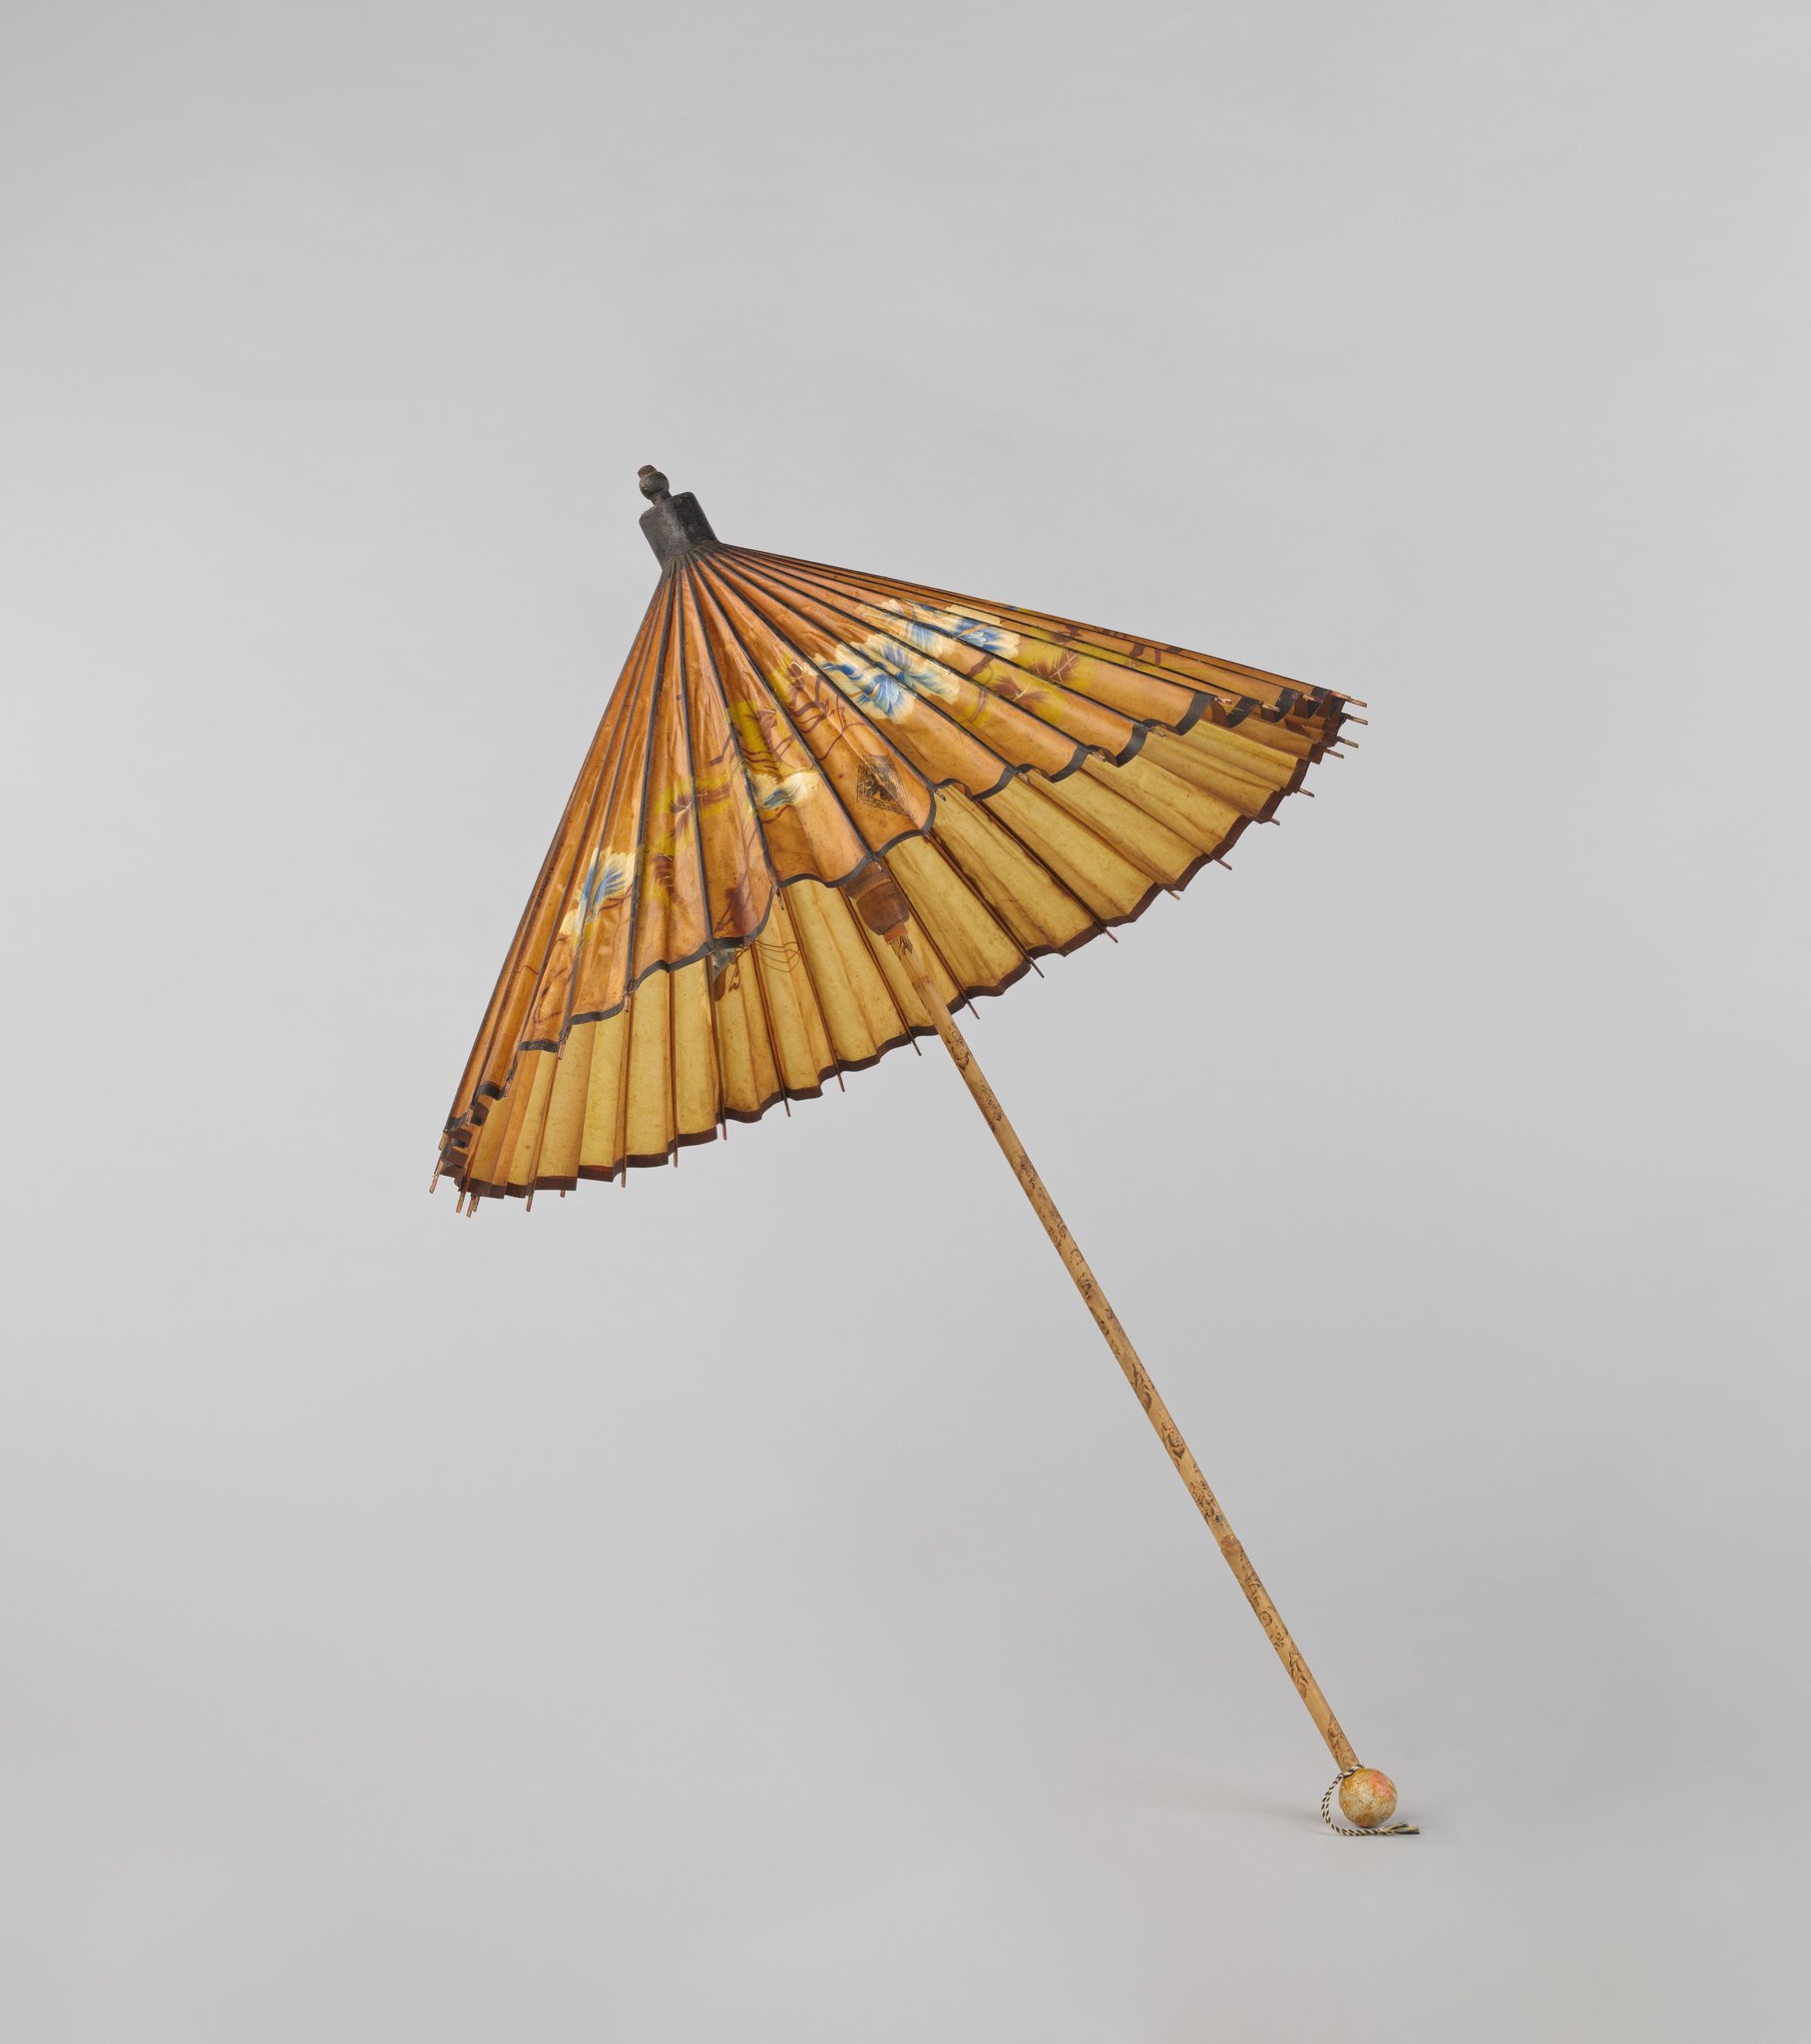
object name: parasol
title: Parasol van papier met schildering met tak met blauwe bloemen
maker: Anonymous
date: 1850-1950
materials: bamboo, paint, textile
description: De parasol heeft een stok van bamboe met daarin gebrande decoraties. De handgreep heeft een bolvorm.